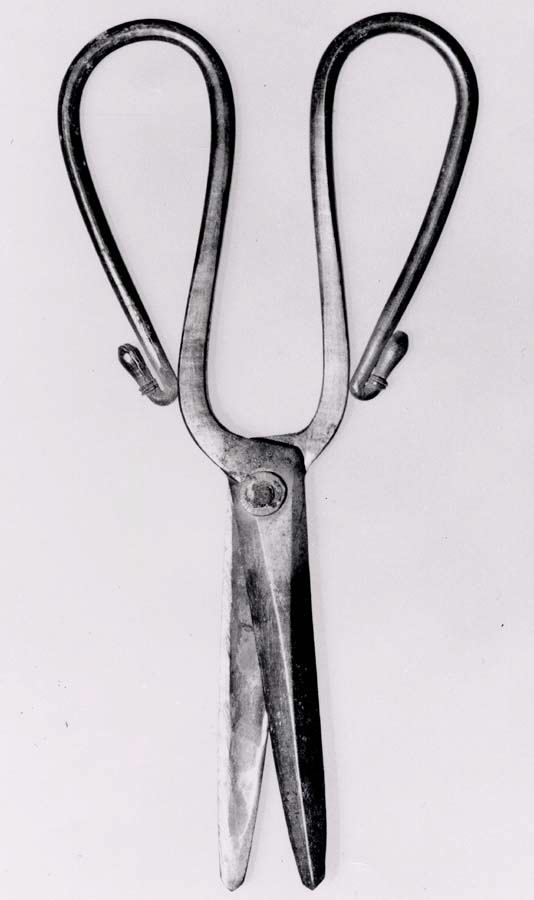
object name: scissors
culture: korean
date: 918-1392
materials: bronze